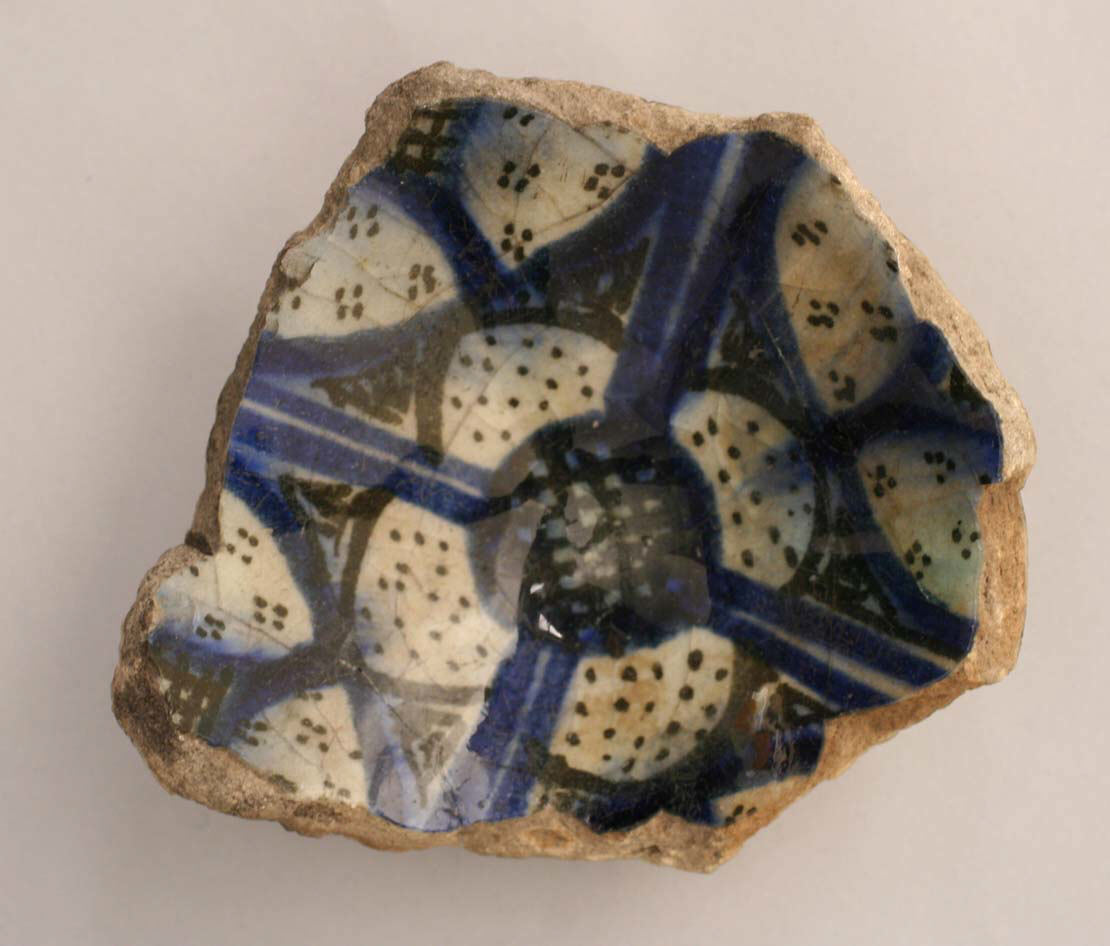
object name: fragment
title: Ceramic Fragment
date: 1301-1400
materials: glaze, stonepaste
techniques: painting, polychrome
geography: egypt or syria